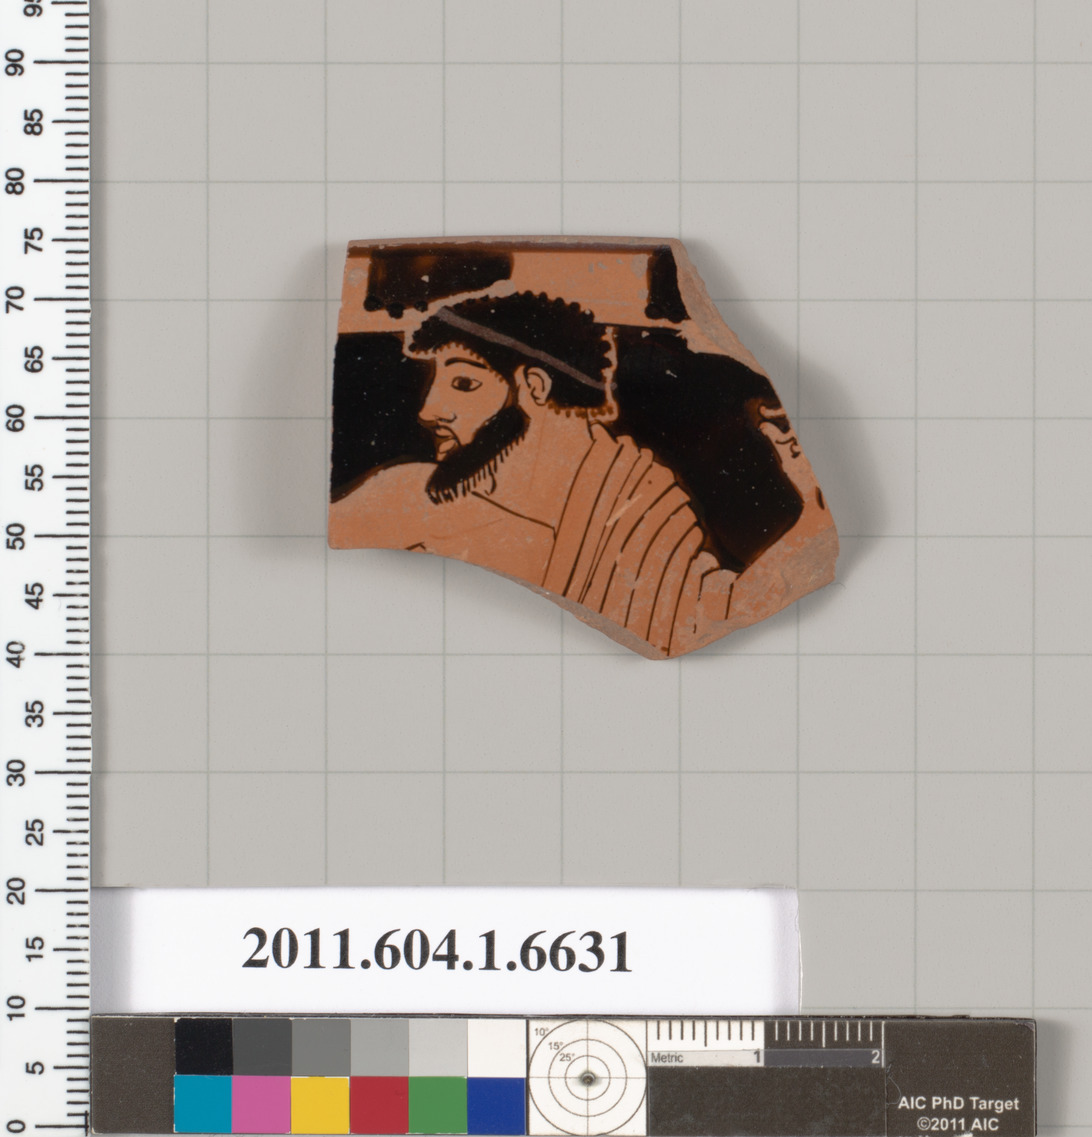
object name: kylix fragment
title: Terracotta rim fragment of a kylix (drinking cup)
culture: greek, attic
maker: castelgiorgio painter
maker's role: artist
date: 490-470 BCE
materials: terracotta